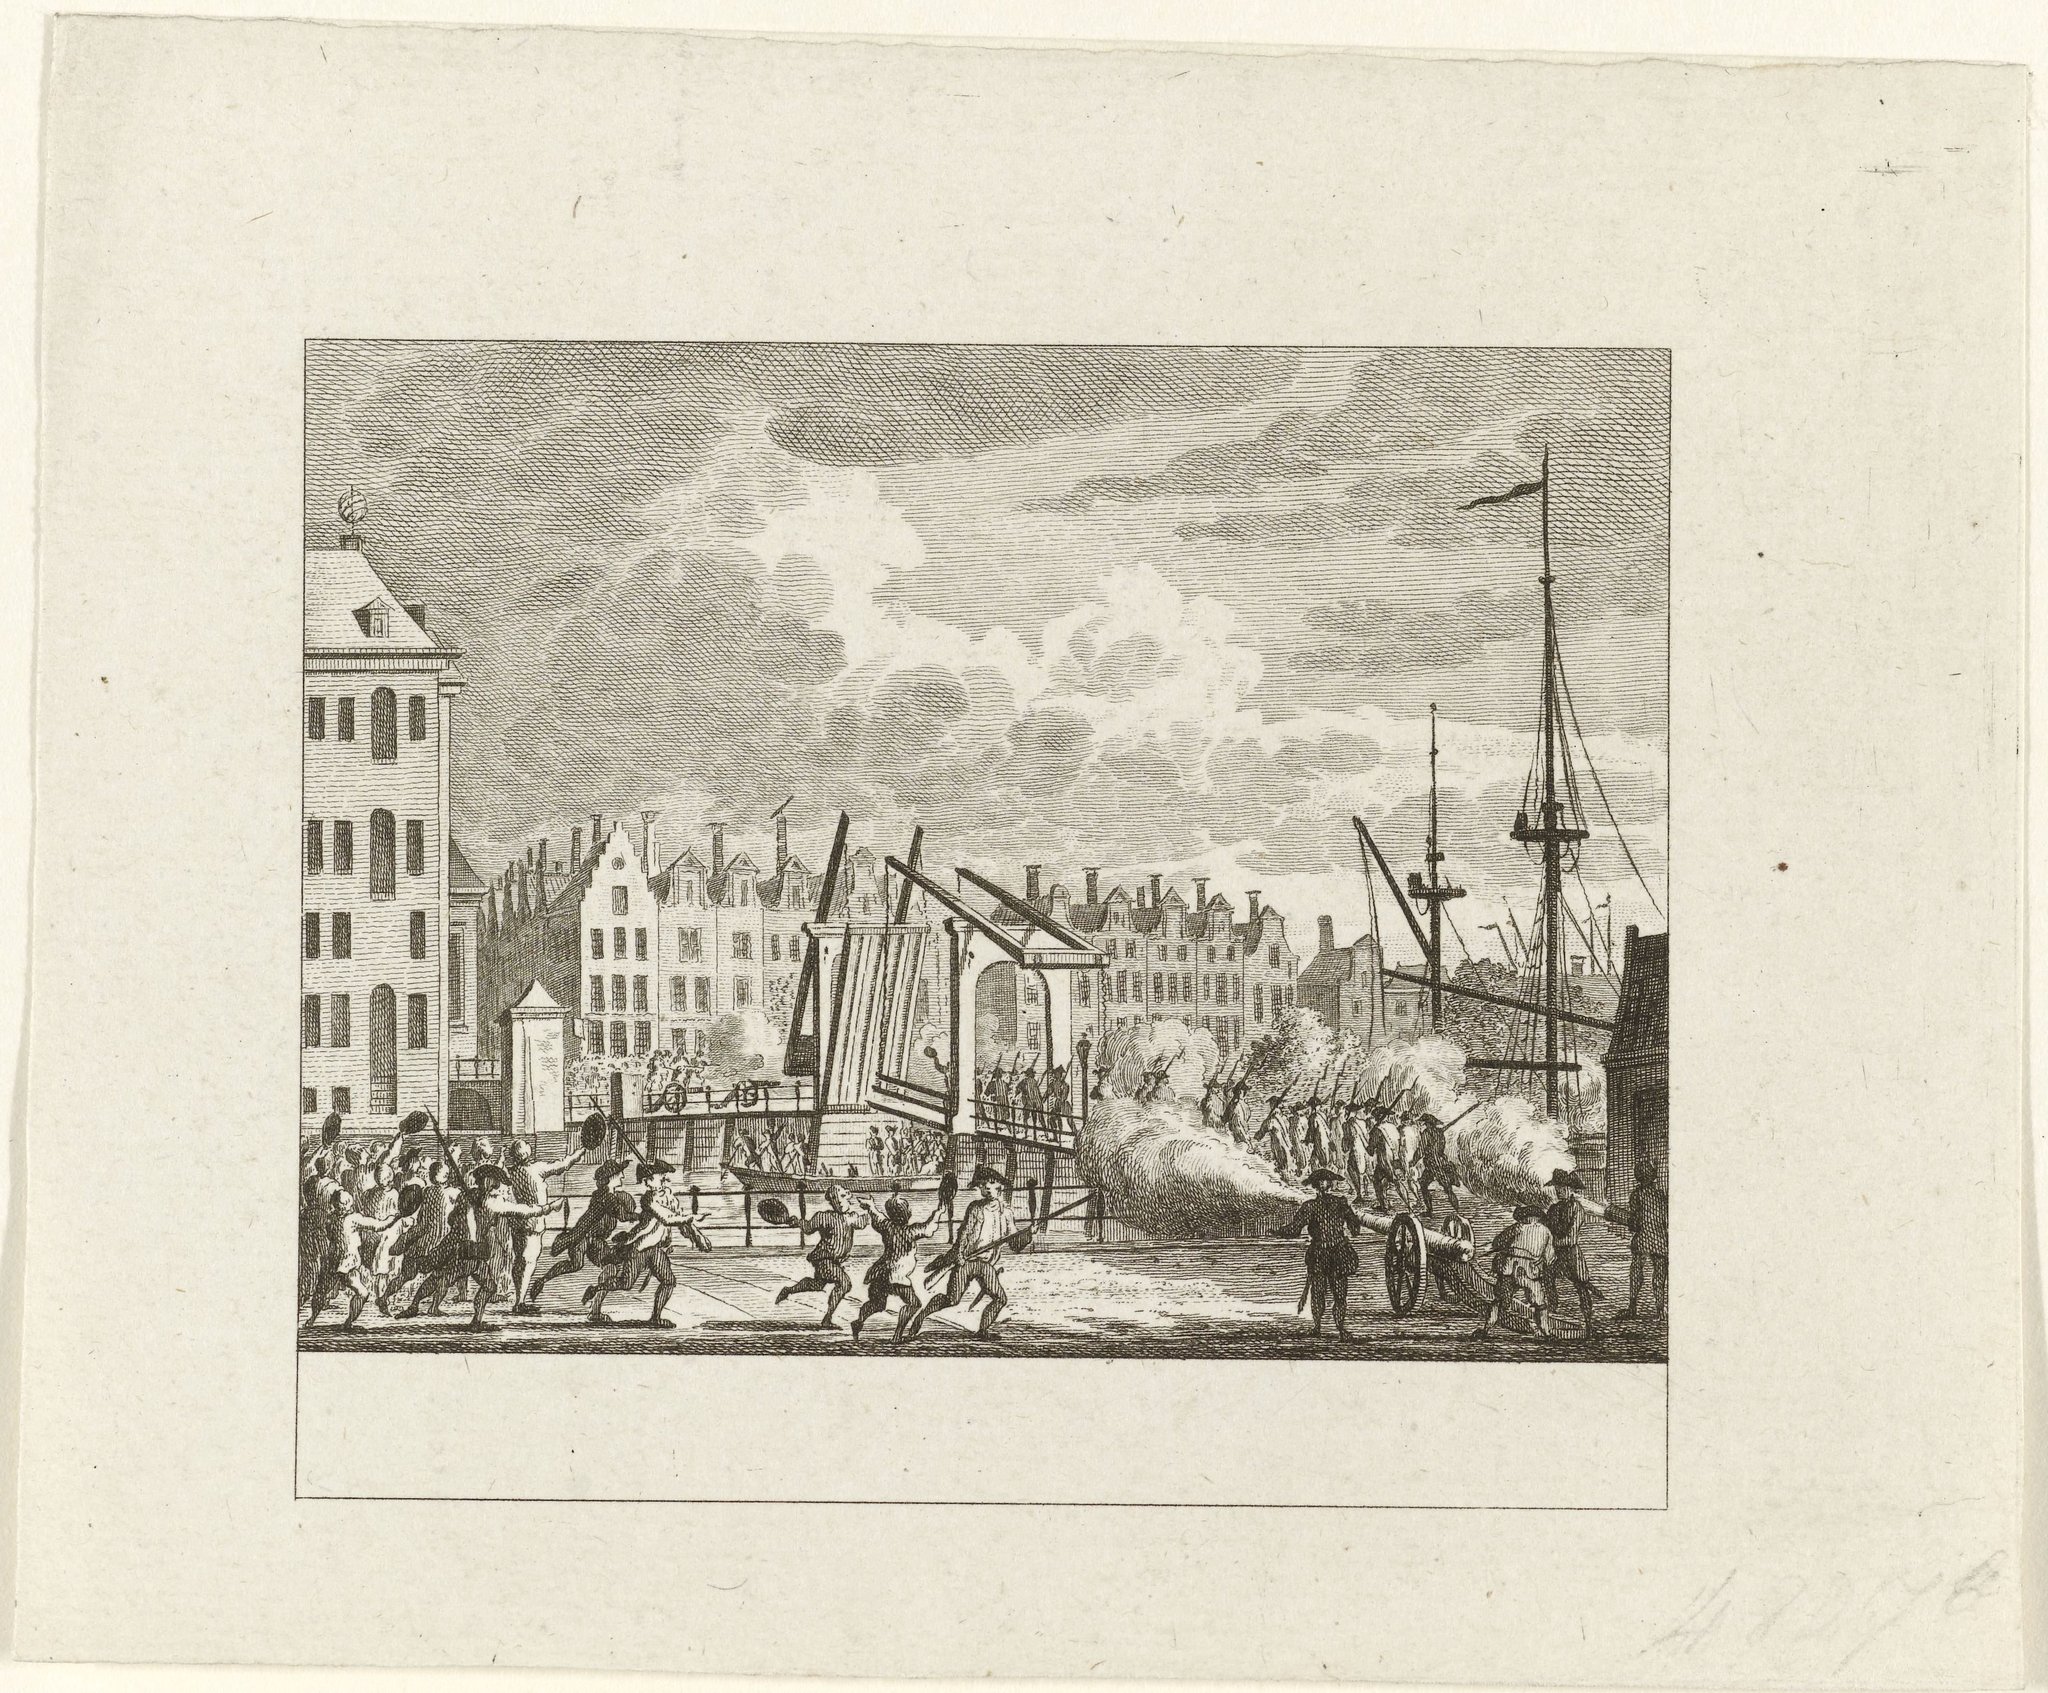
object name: print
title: Verovering van de Kattenburgerbrug, 1787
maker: cornelis brouwer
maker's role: print maker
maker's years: 1731-1803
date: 1787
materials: paper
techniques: engraving, etching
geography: northern netherlands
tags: battle (+ citizen soldiery, civil guard, citizen militia)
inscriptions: collector's mark: Lugt 2228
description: De verovering van de Kattenburgerbrug naar het eiland Kattenburg op de opstandige Oranjegezinden door de gewapende Amsterdamse burgers, 30 mei 1787.